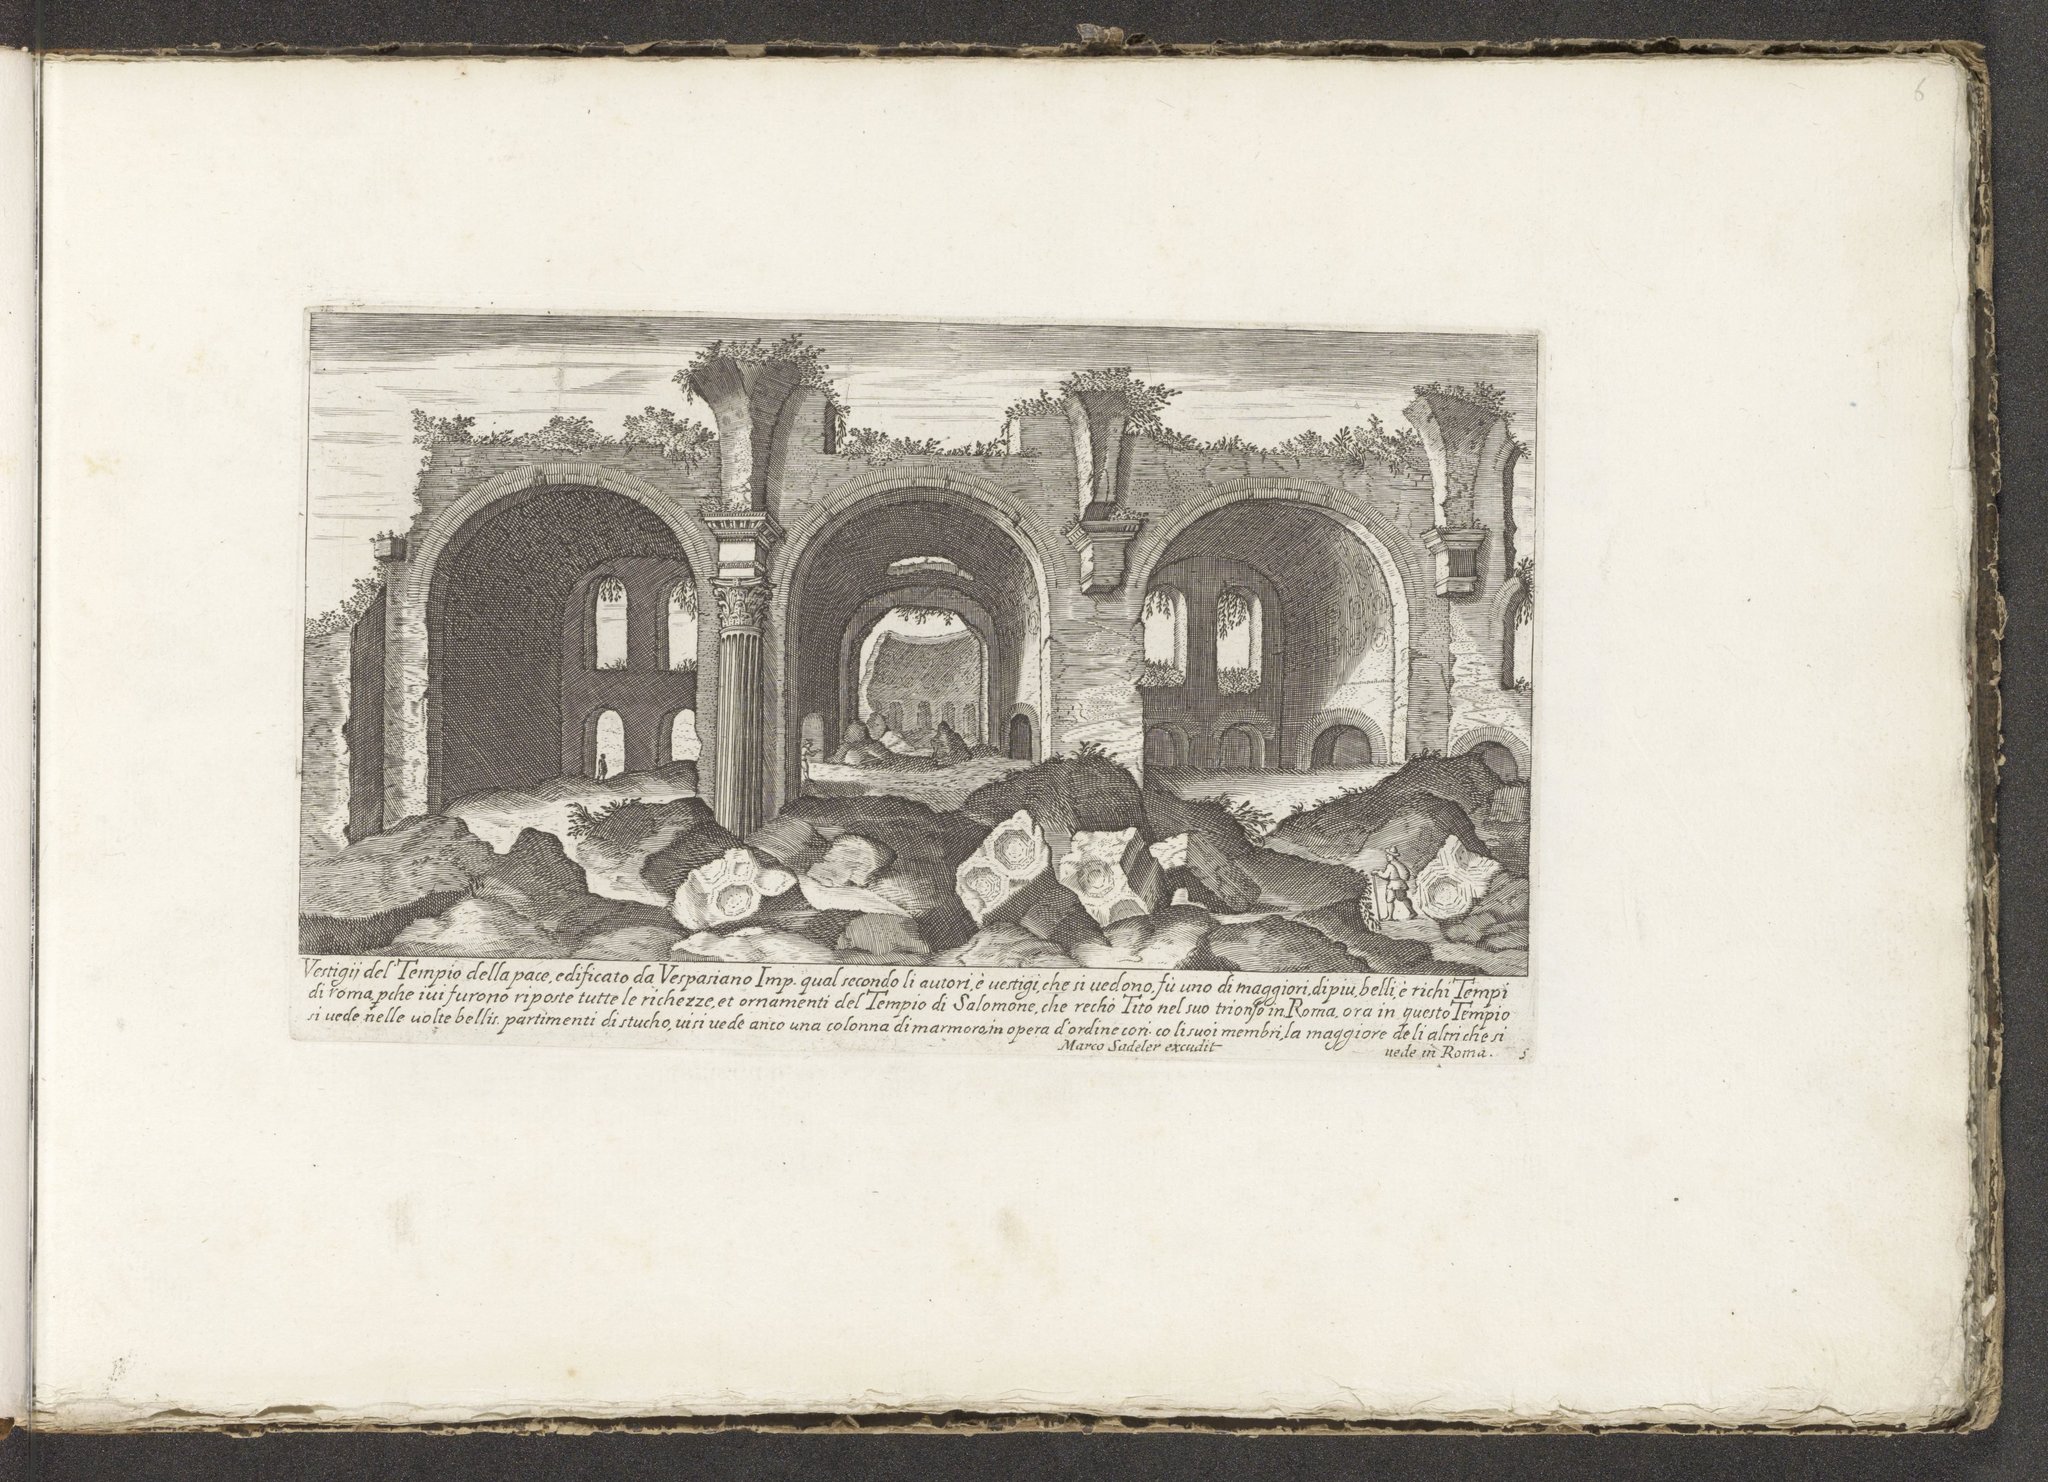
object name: print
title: Vestigi delle antichita di Roma, Tivoli, Pozzuolo et altri luochi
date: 1680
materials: paper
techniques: engraving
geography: prague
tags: basilica van maxentius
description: Basilica van Maxentius, in het onderschrift verward met de Tempio della Pace. In de ondermarge vier regels tekst in het Italiaans. De prent maakt deel uit van een album.